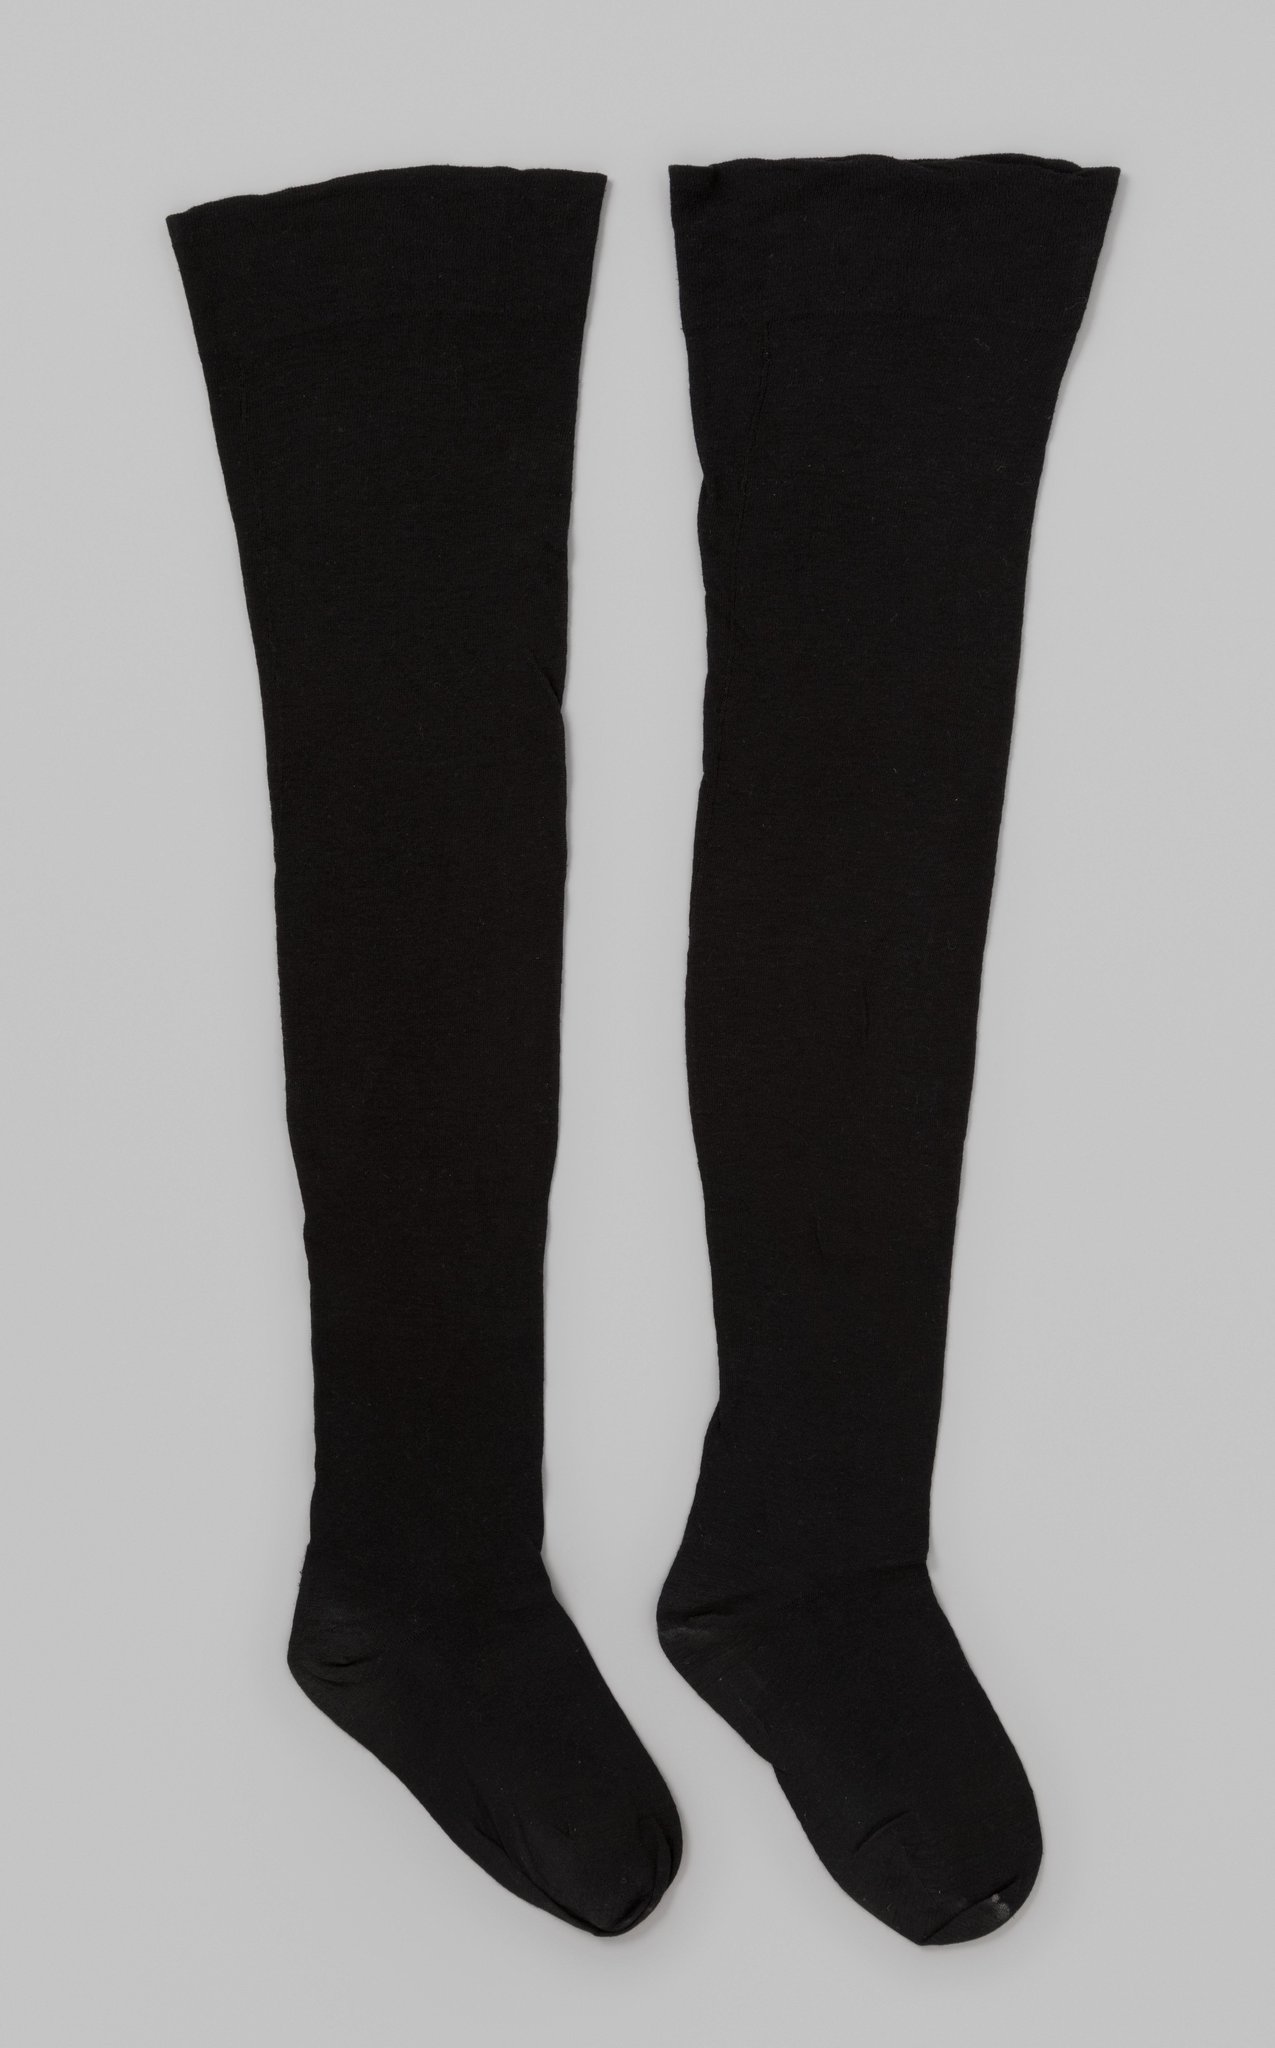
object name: clothing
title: Kous van effen zwarte katoenen tricot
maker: Anonymous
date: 1920-1950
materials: cotton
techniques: knitting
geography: netherlands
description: Kous van katoenen tricot. Brede naar binnengeslagen boord, waarop een vervaagd wit opschrift.